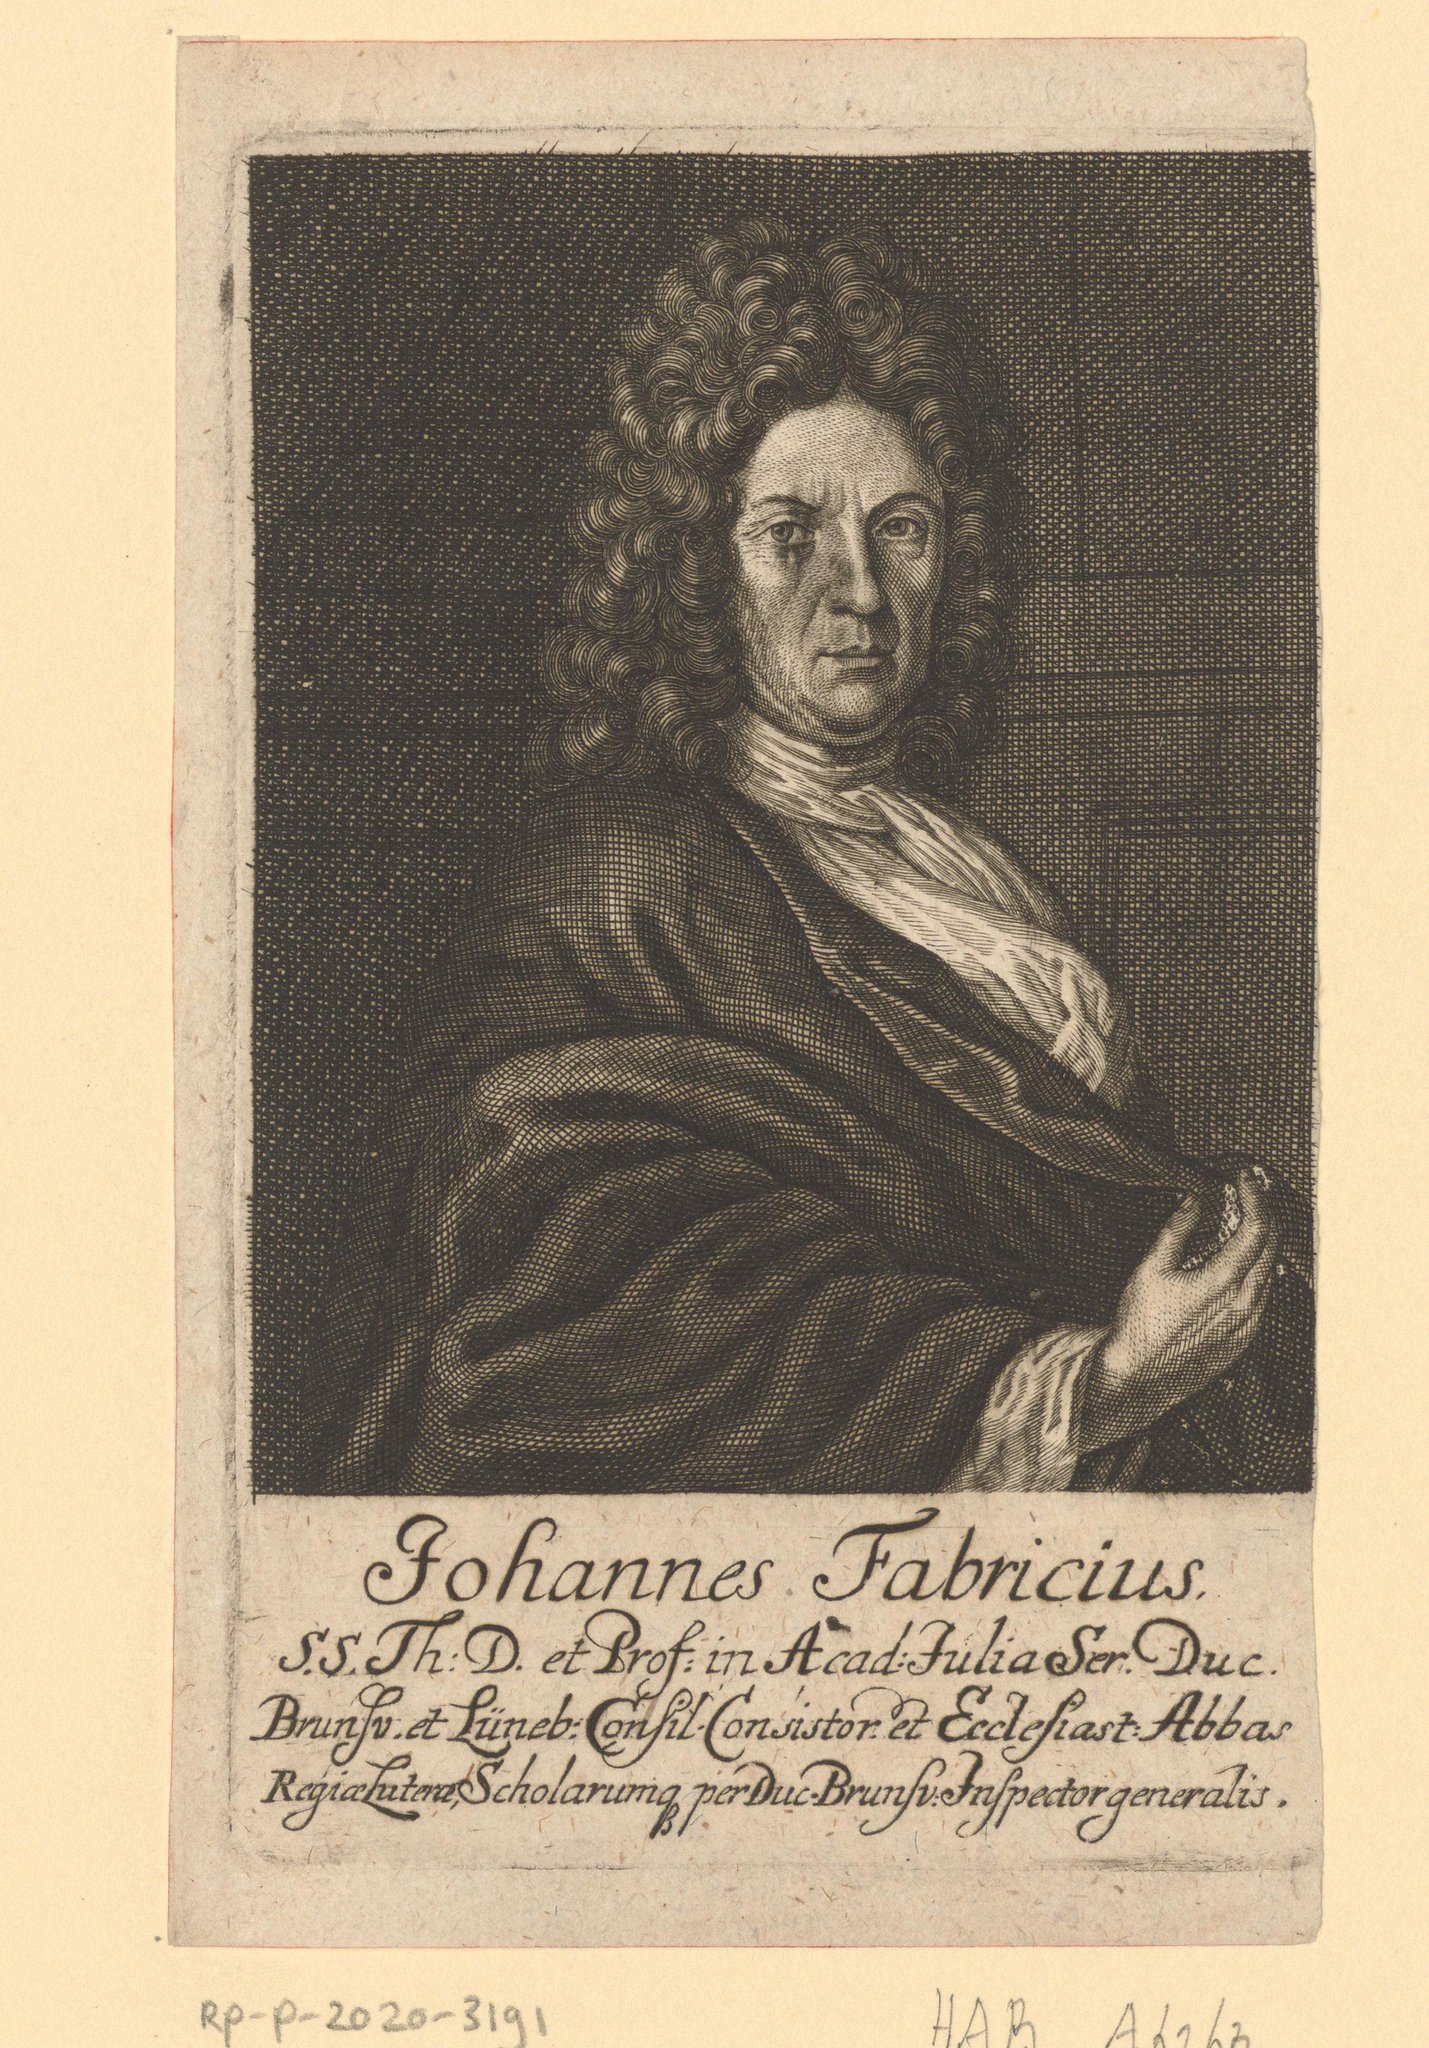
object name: print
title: Portret van Johann Fabricius IV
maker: Anonymous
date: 1680-1730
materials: paper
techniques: engraving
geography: germany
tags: theologian, historical persons